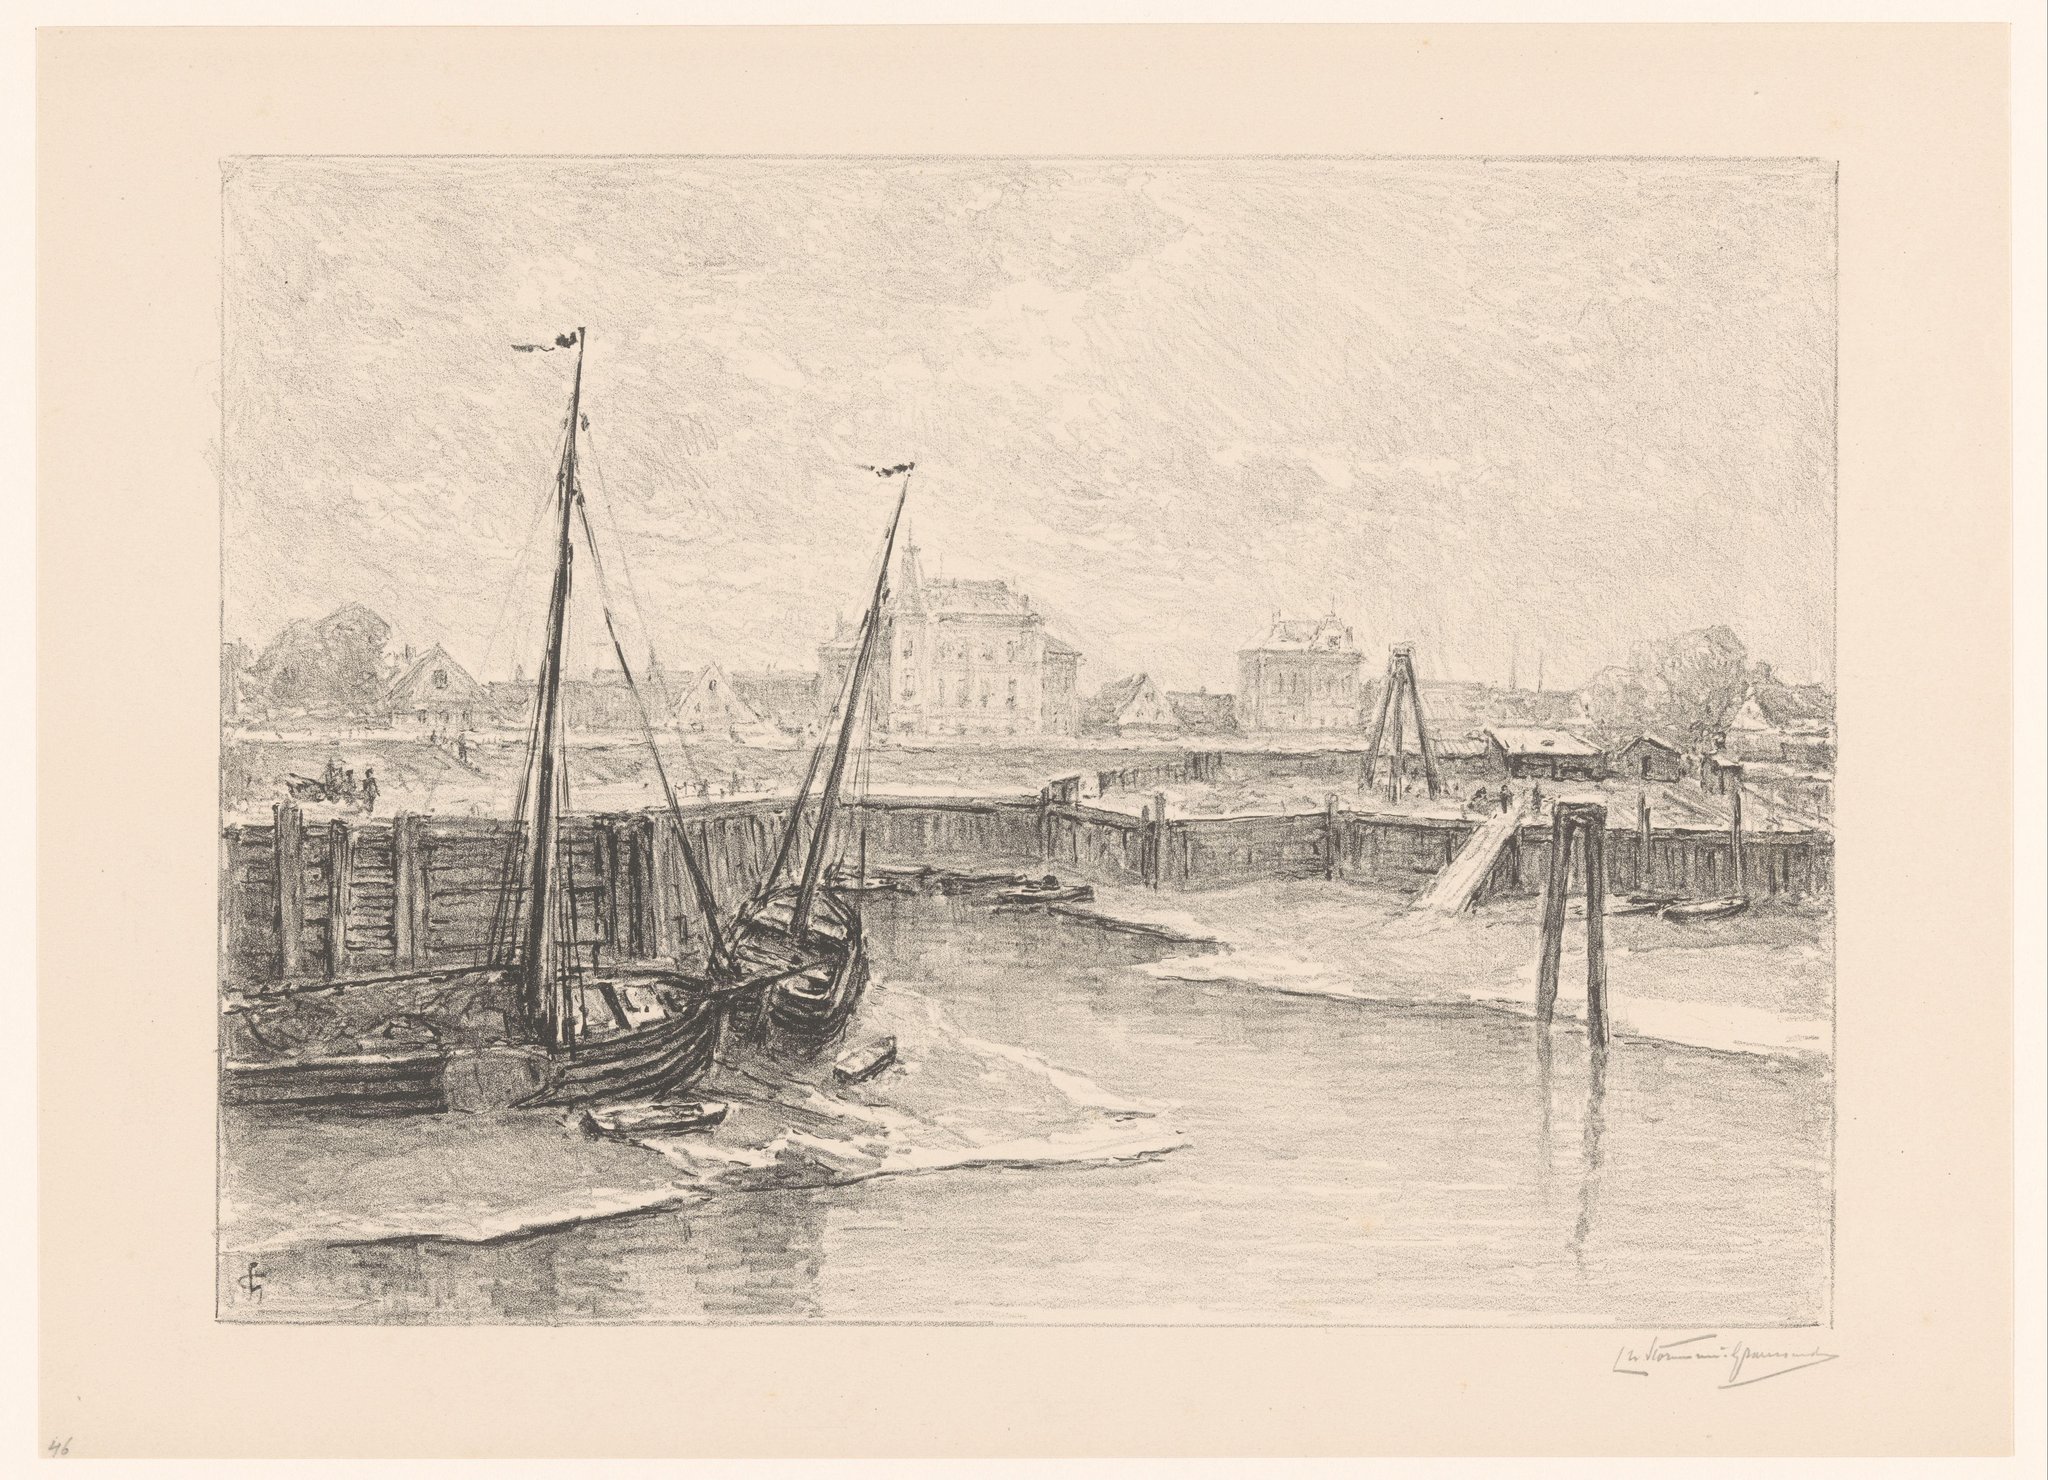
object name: print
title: Haven bij Kopenhagen bij laag water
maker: carel nicolaas storm van s-gravesande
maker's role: draughtsman, print maker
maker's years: 1841-1924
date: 1851-1924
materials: paper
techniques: lithograph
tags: harbour, ebb, low tide, sailing-ship, sailing-boat, copenhagen (city)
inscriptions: collector's mark: Lugt 2228, number: ‘46’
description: Mogelijk vermeld in: Storm van 's-Gravesande, Charles. Catalogue des eaux-fortes et lithographies. New York: s.n., 1903, of in een onbekende latere uitgave van het manuscript. Vermoedelijk vermeld als catalogusnummer 46.